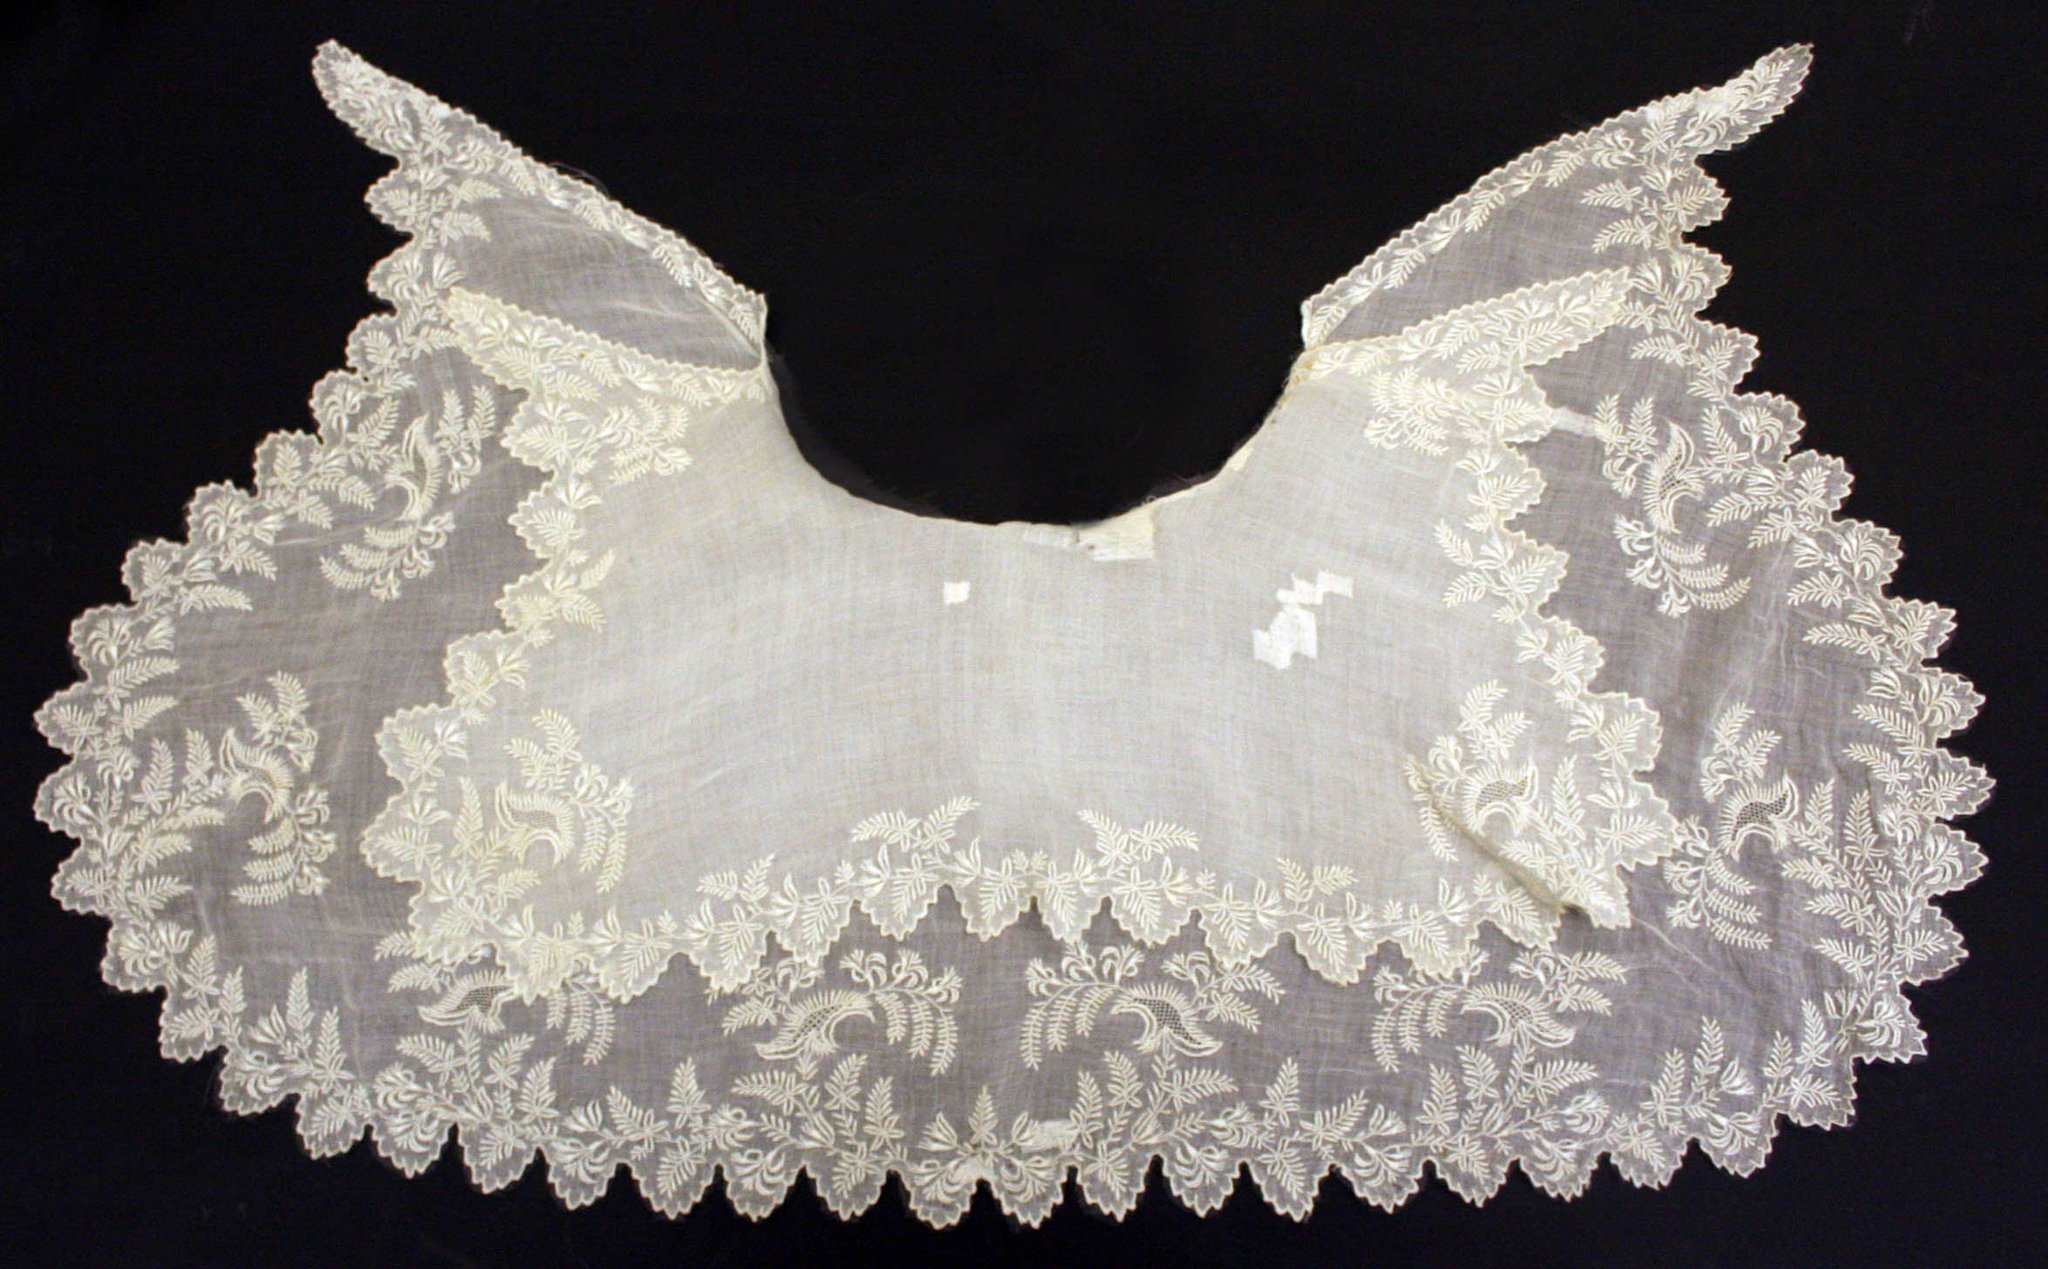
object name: pelerine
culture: british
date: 1830-1839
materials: cotton